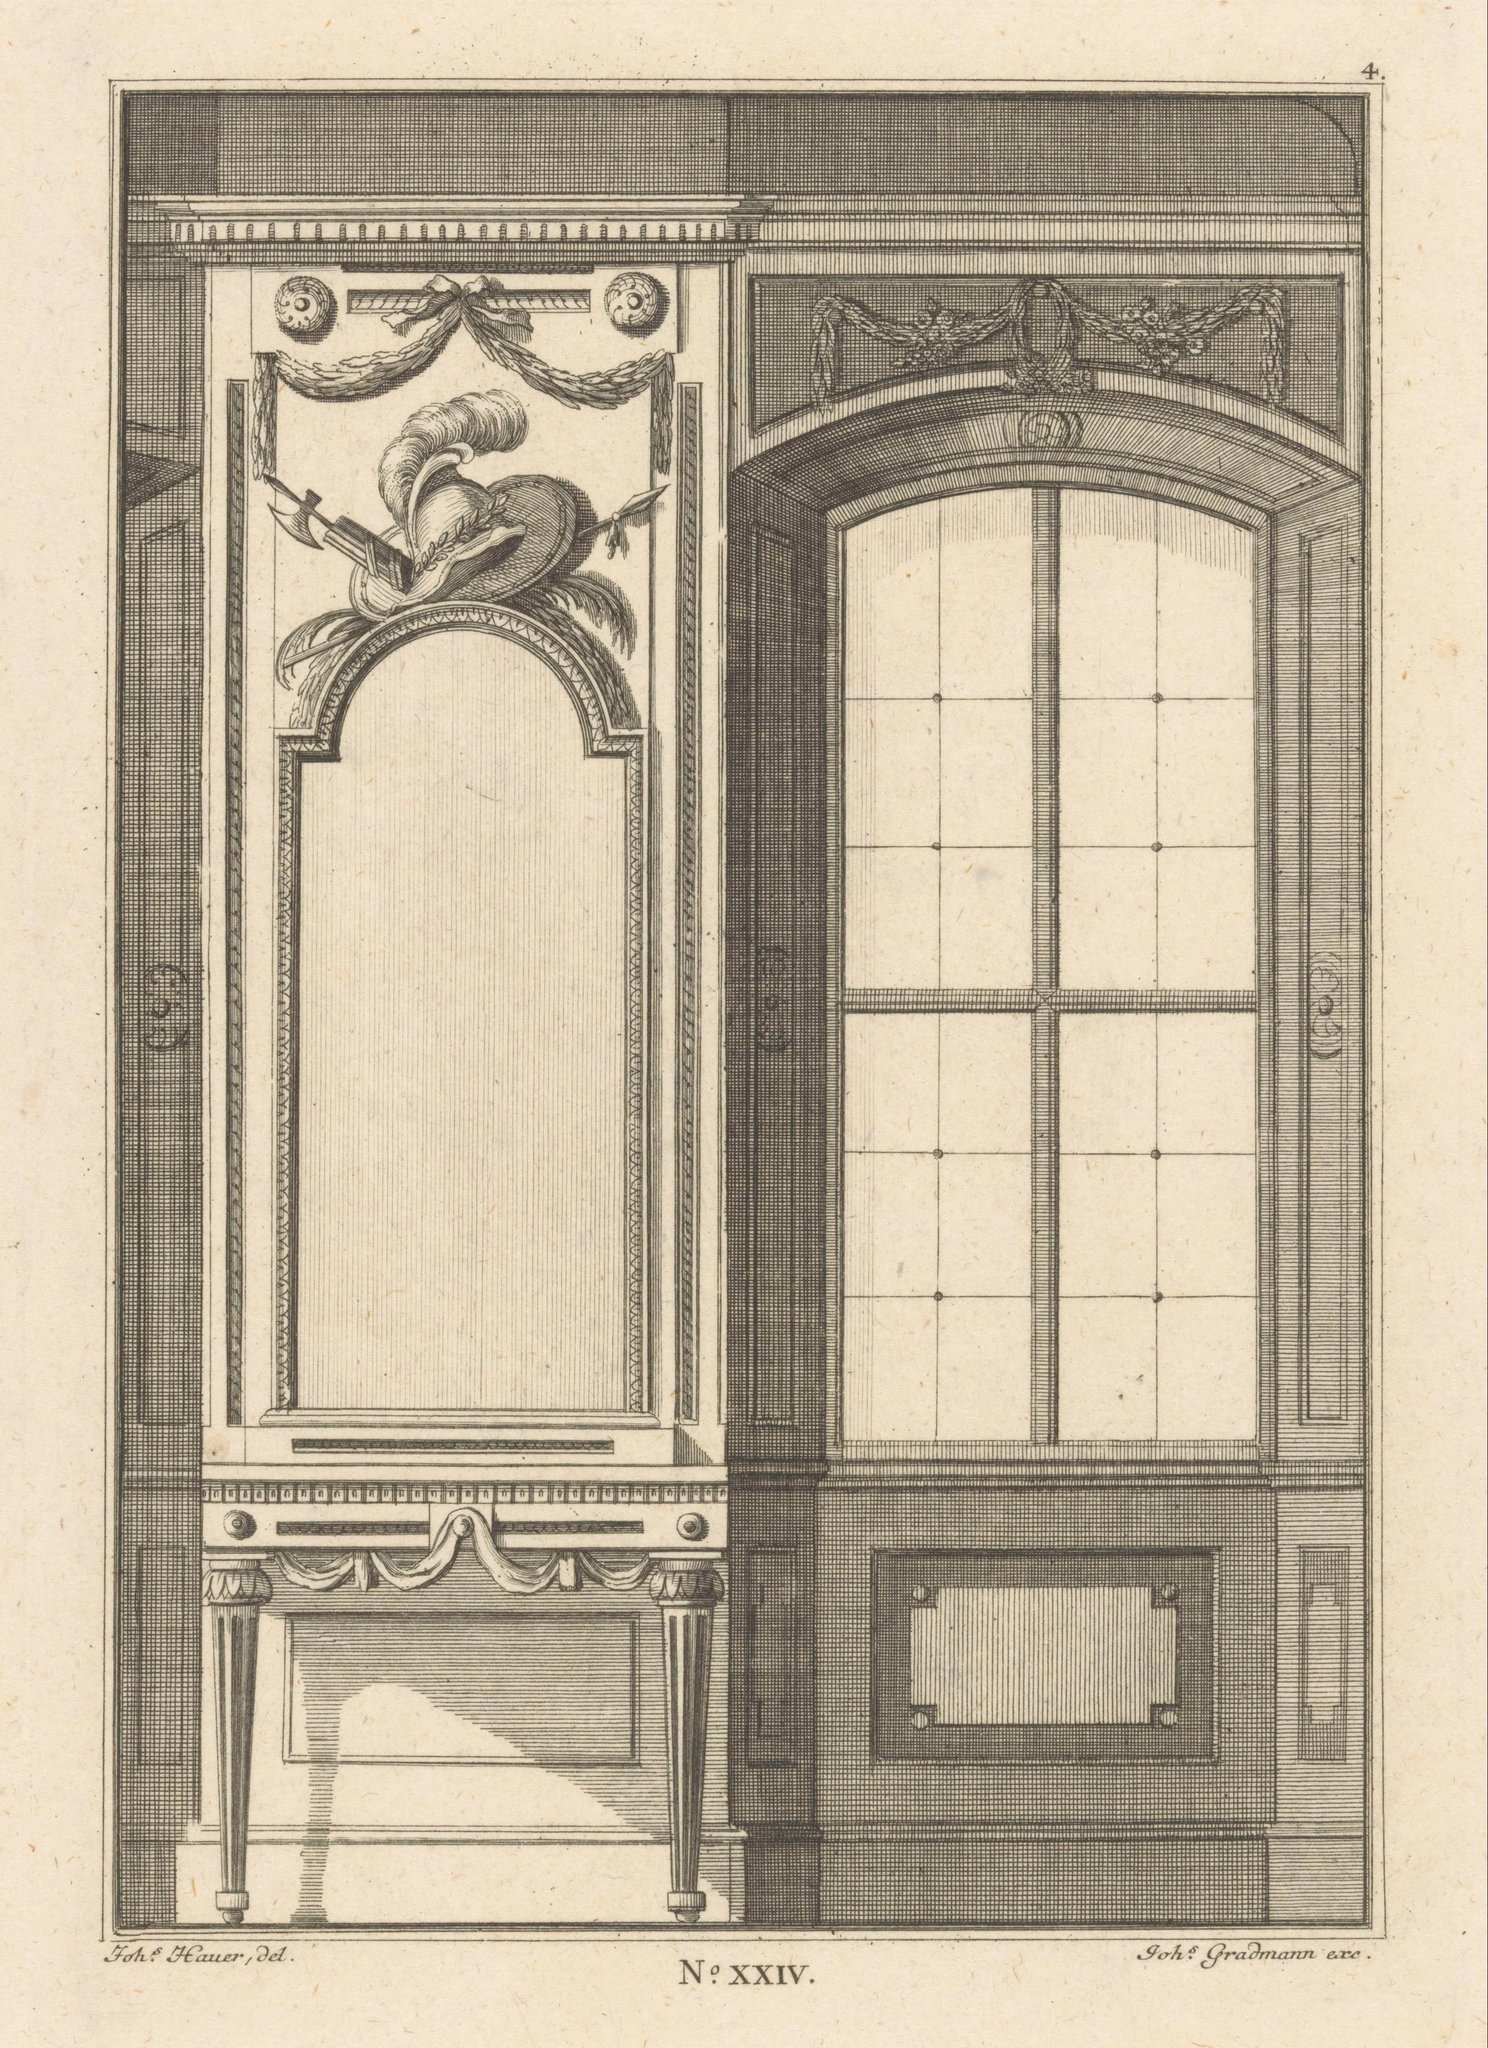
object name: ornament print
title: Spiegel met helm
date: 1758-1820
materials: paper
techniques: engraving, etching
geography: ravensburg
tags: helmet, mirror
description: Ontwerp voor een wandspiegel met een tafel, gedecoreerd met guirlandes, een schild, helm en wapens. Rechts een raam. Uitgeversnummer XXIV.